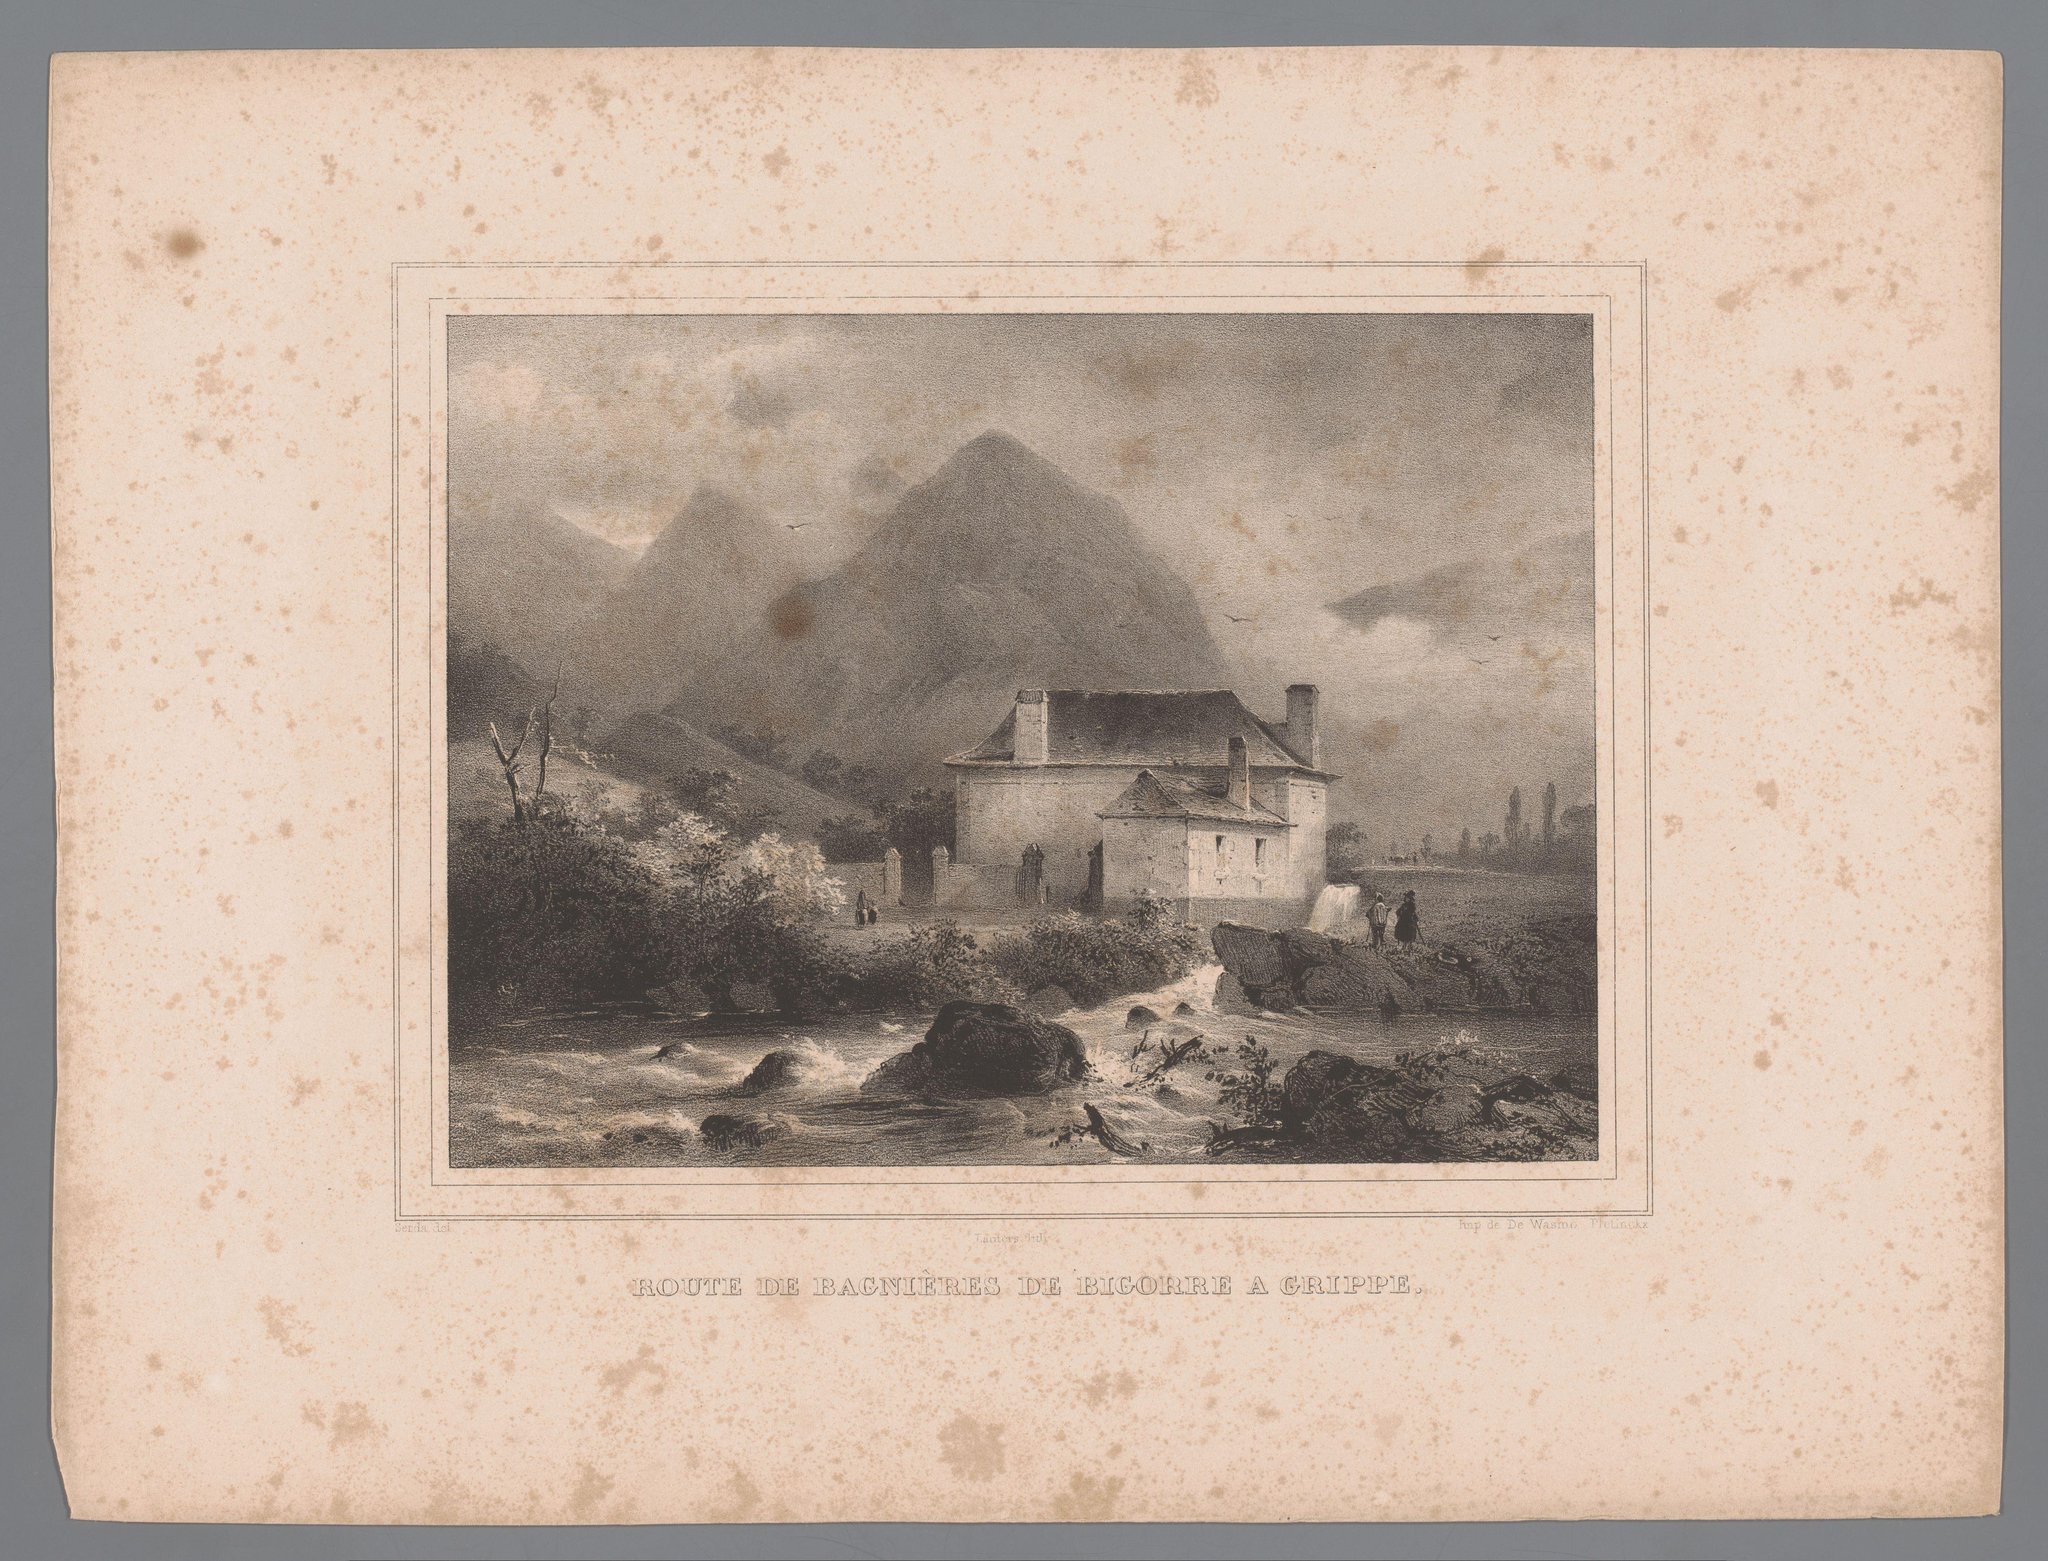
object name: print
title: Route de Bagnières de Bigorre a Grippe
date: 1816-1851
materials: paper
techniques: lithograph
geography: brussels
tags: river, mountains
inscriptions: collector's mark: Lugt 2228